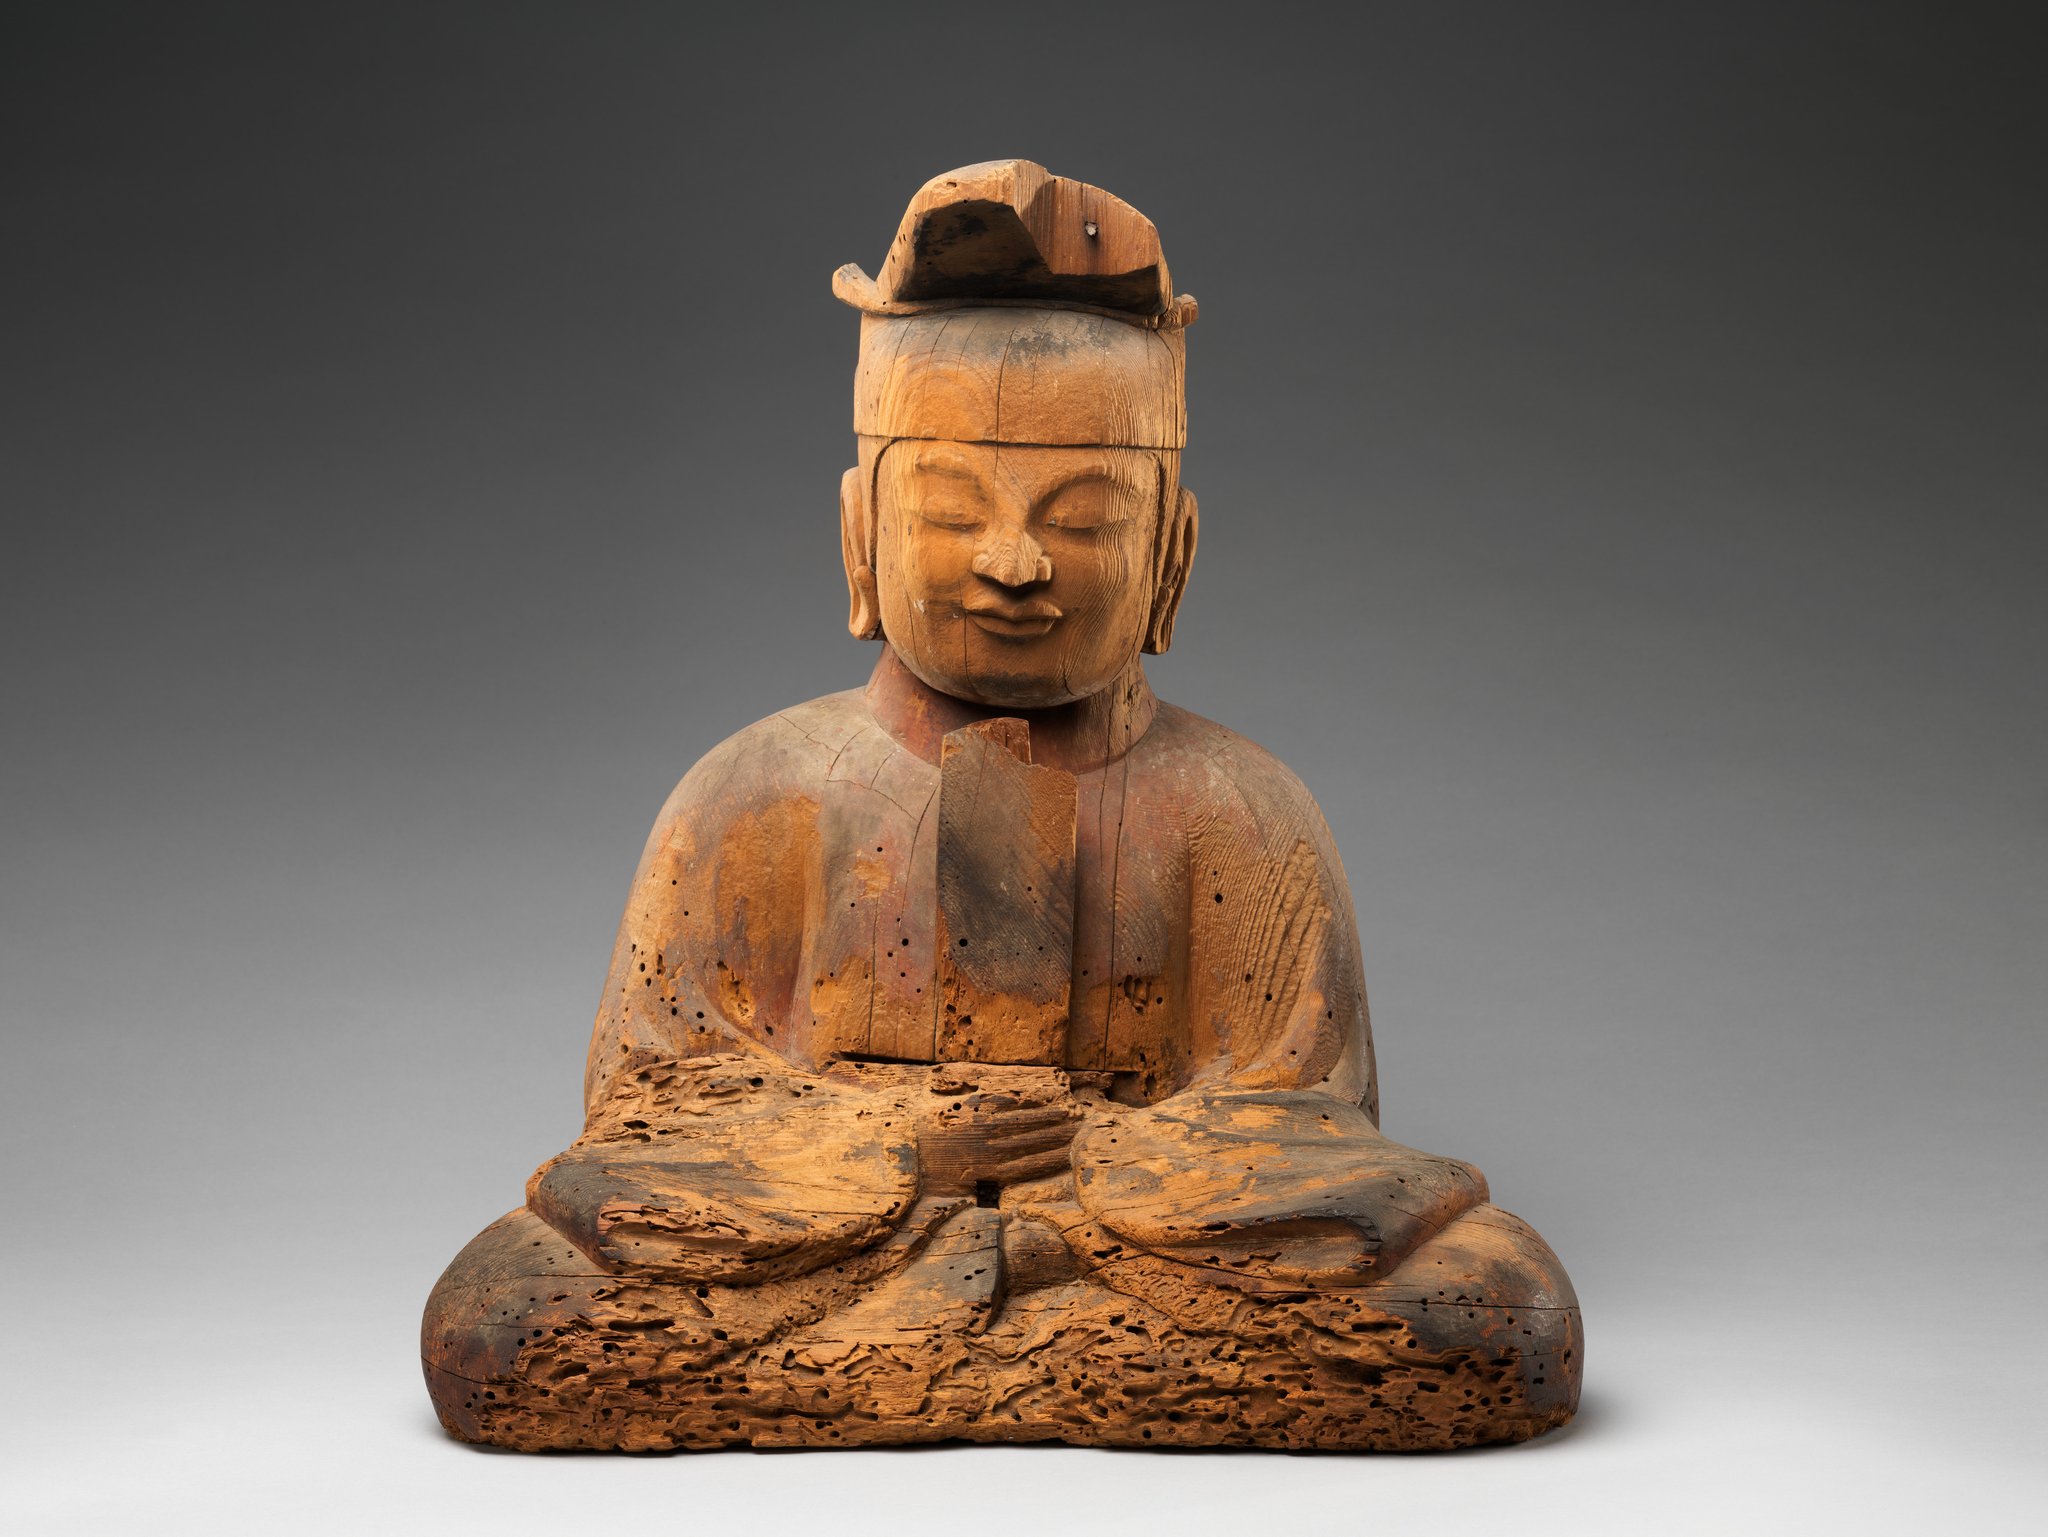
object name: figure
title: Male and Female Shinto Deities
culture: japanese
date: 901-1000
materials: wood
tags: deities,shintō